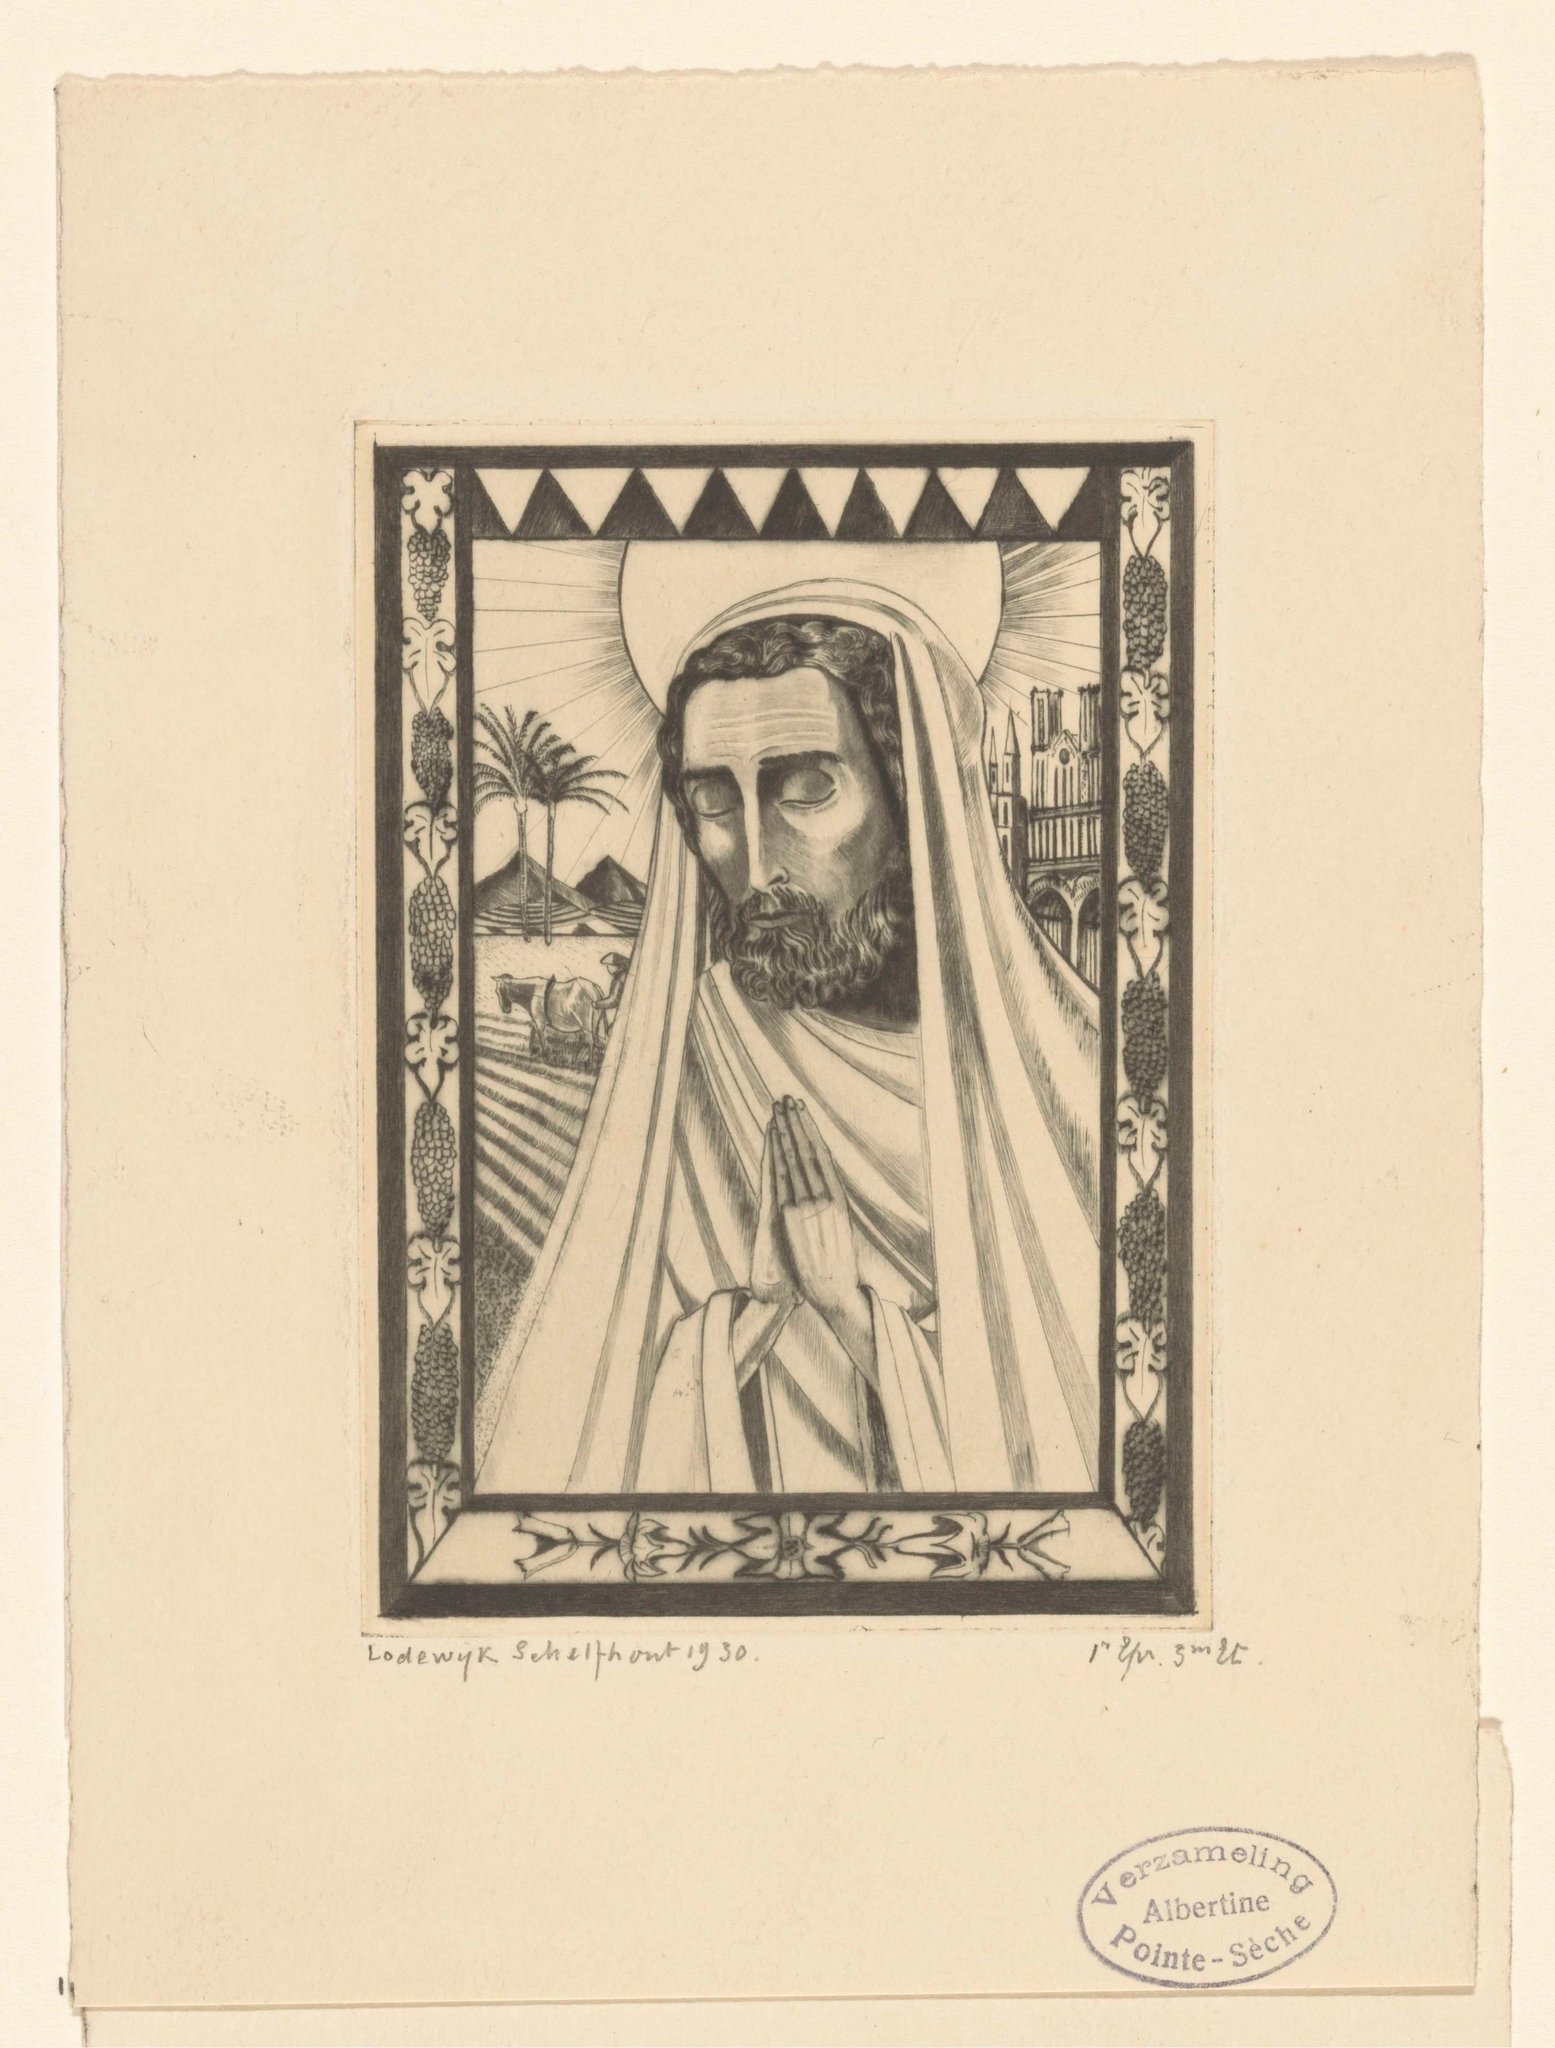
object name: print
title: Jozef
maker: lodewijk schelfhout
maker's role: draughtsman, print maker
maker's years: 1881-1943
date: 1930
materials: paper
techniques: drypoint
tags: the foster-father of christ, joseph of nazareth, husband of mary; possible attributes: flowering rod or wand, lily, carpenter's tools, one person praying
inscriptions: collector's mark: Lugt 5i, collector's mark: Lugt 2760, collector's mark: Lugt 2228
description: Jozef, met gevouwen handen en gesloten ogen. Op de achtergrond een landschap met akker, palmbomen, bergen en kerken.